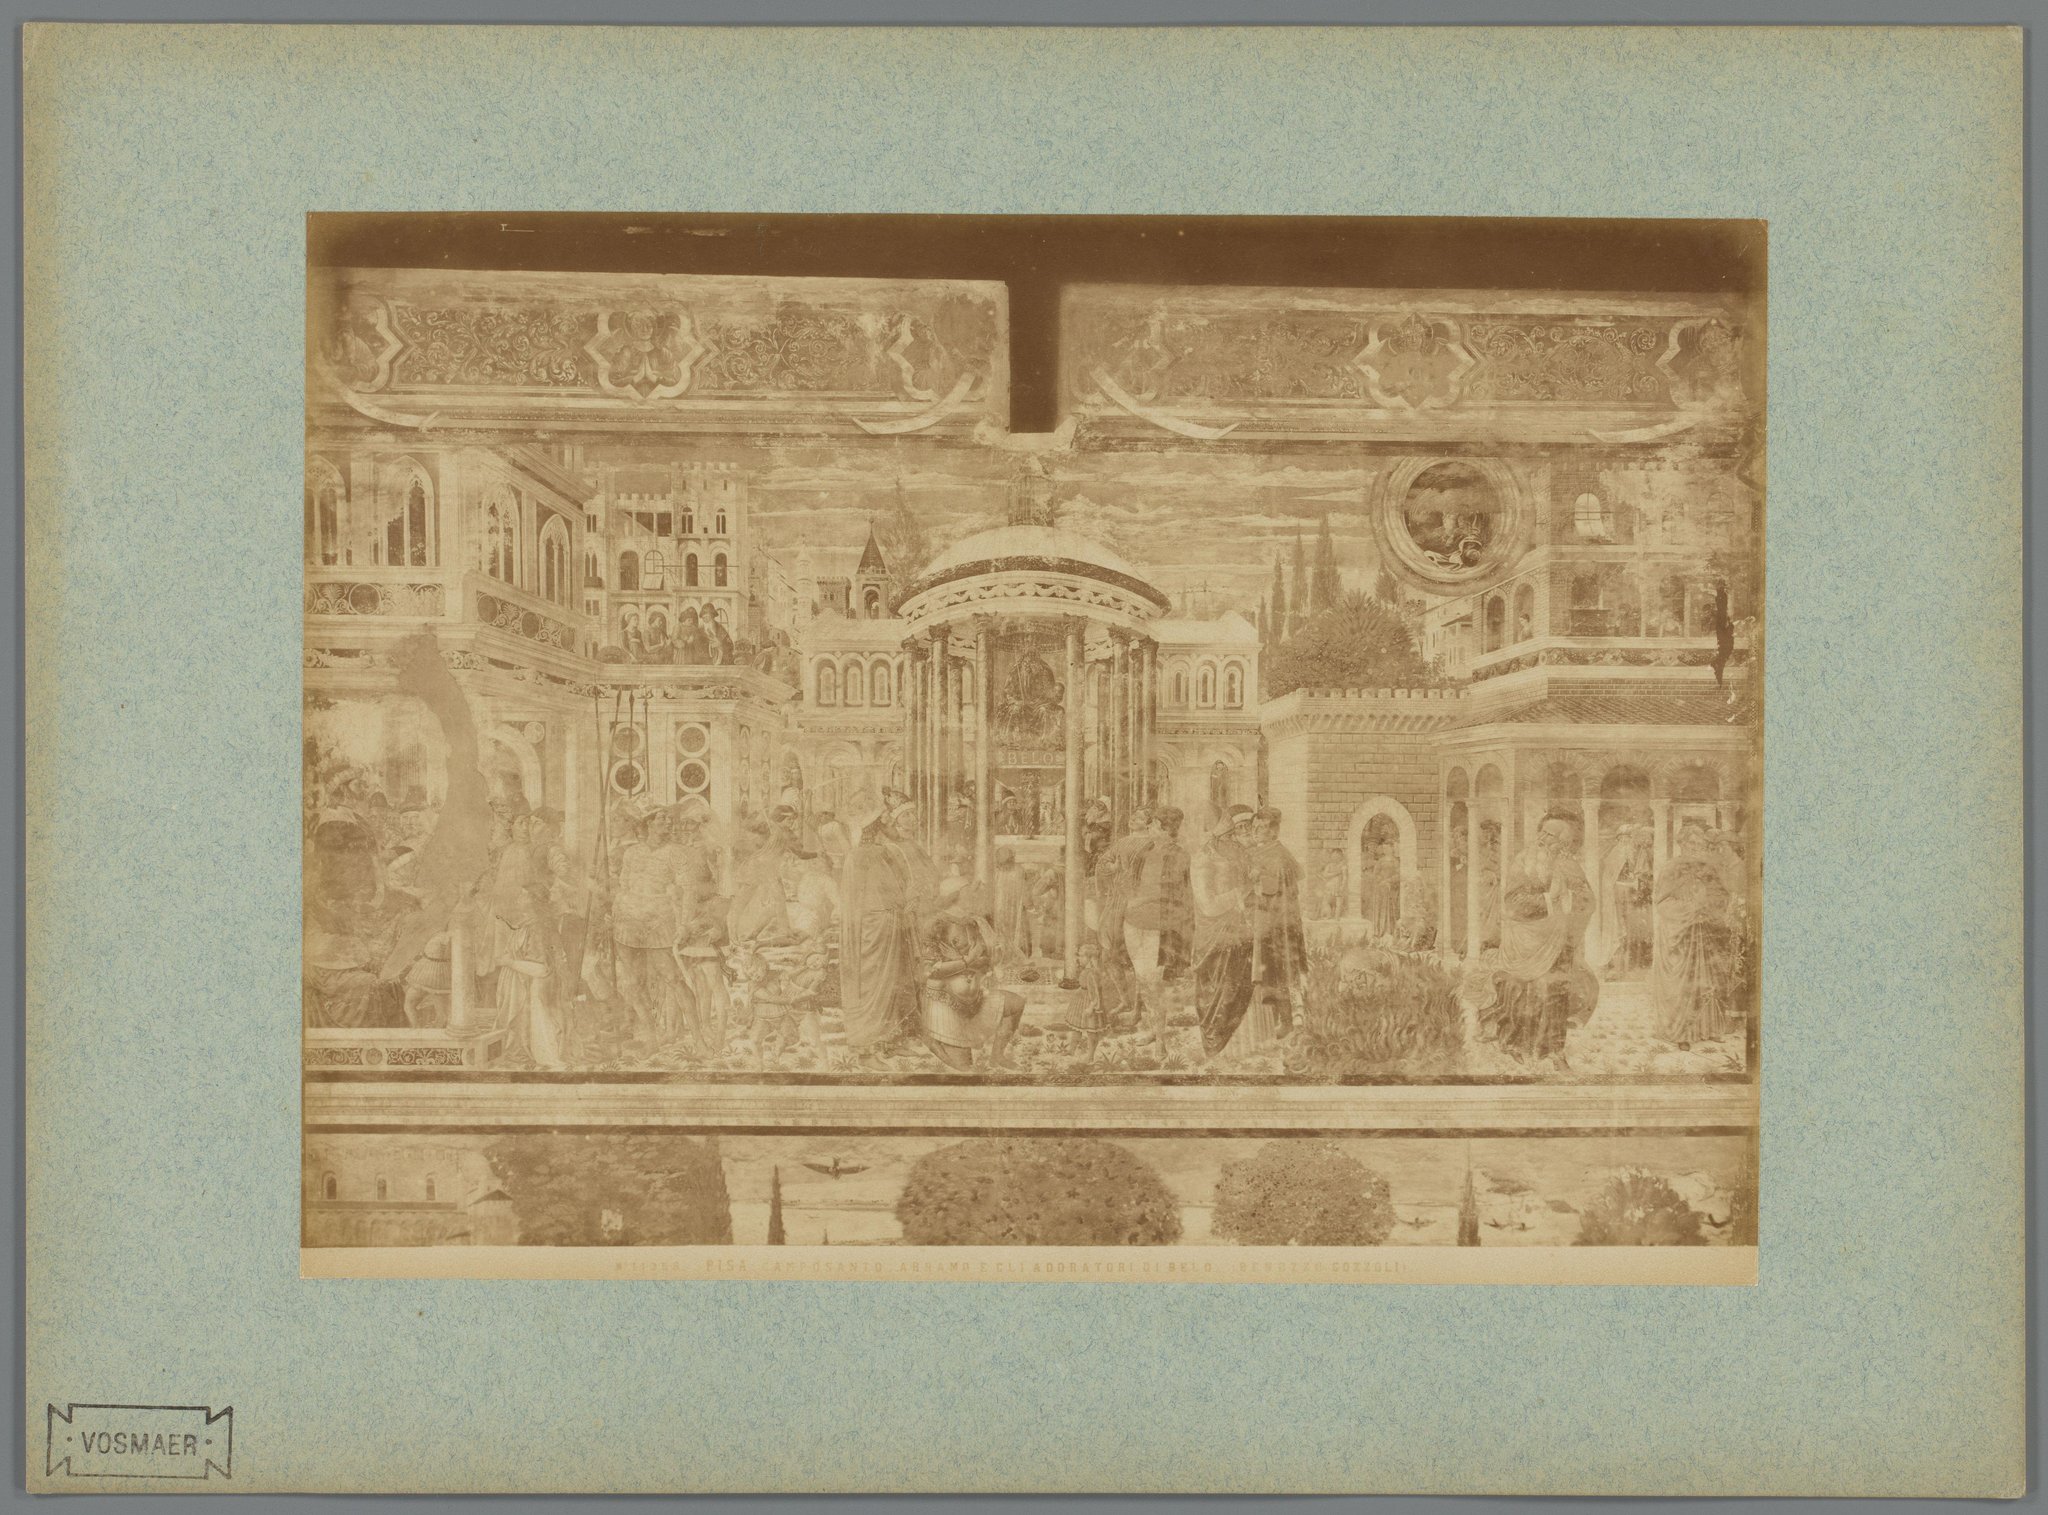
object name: photograph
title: Fotoreproductie van het fresco Abraham en de aanbidders van Belo door Benozzo Gozzoli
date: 1851-1900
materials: cardboard, paper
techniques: albumen print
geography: pisa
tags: wall-covering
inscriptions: number: ‘No. 11358’, collector's mark: ‘VOSMAER’